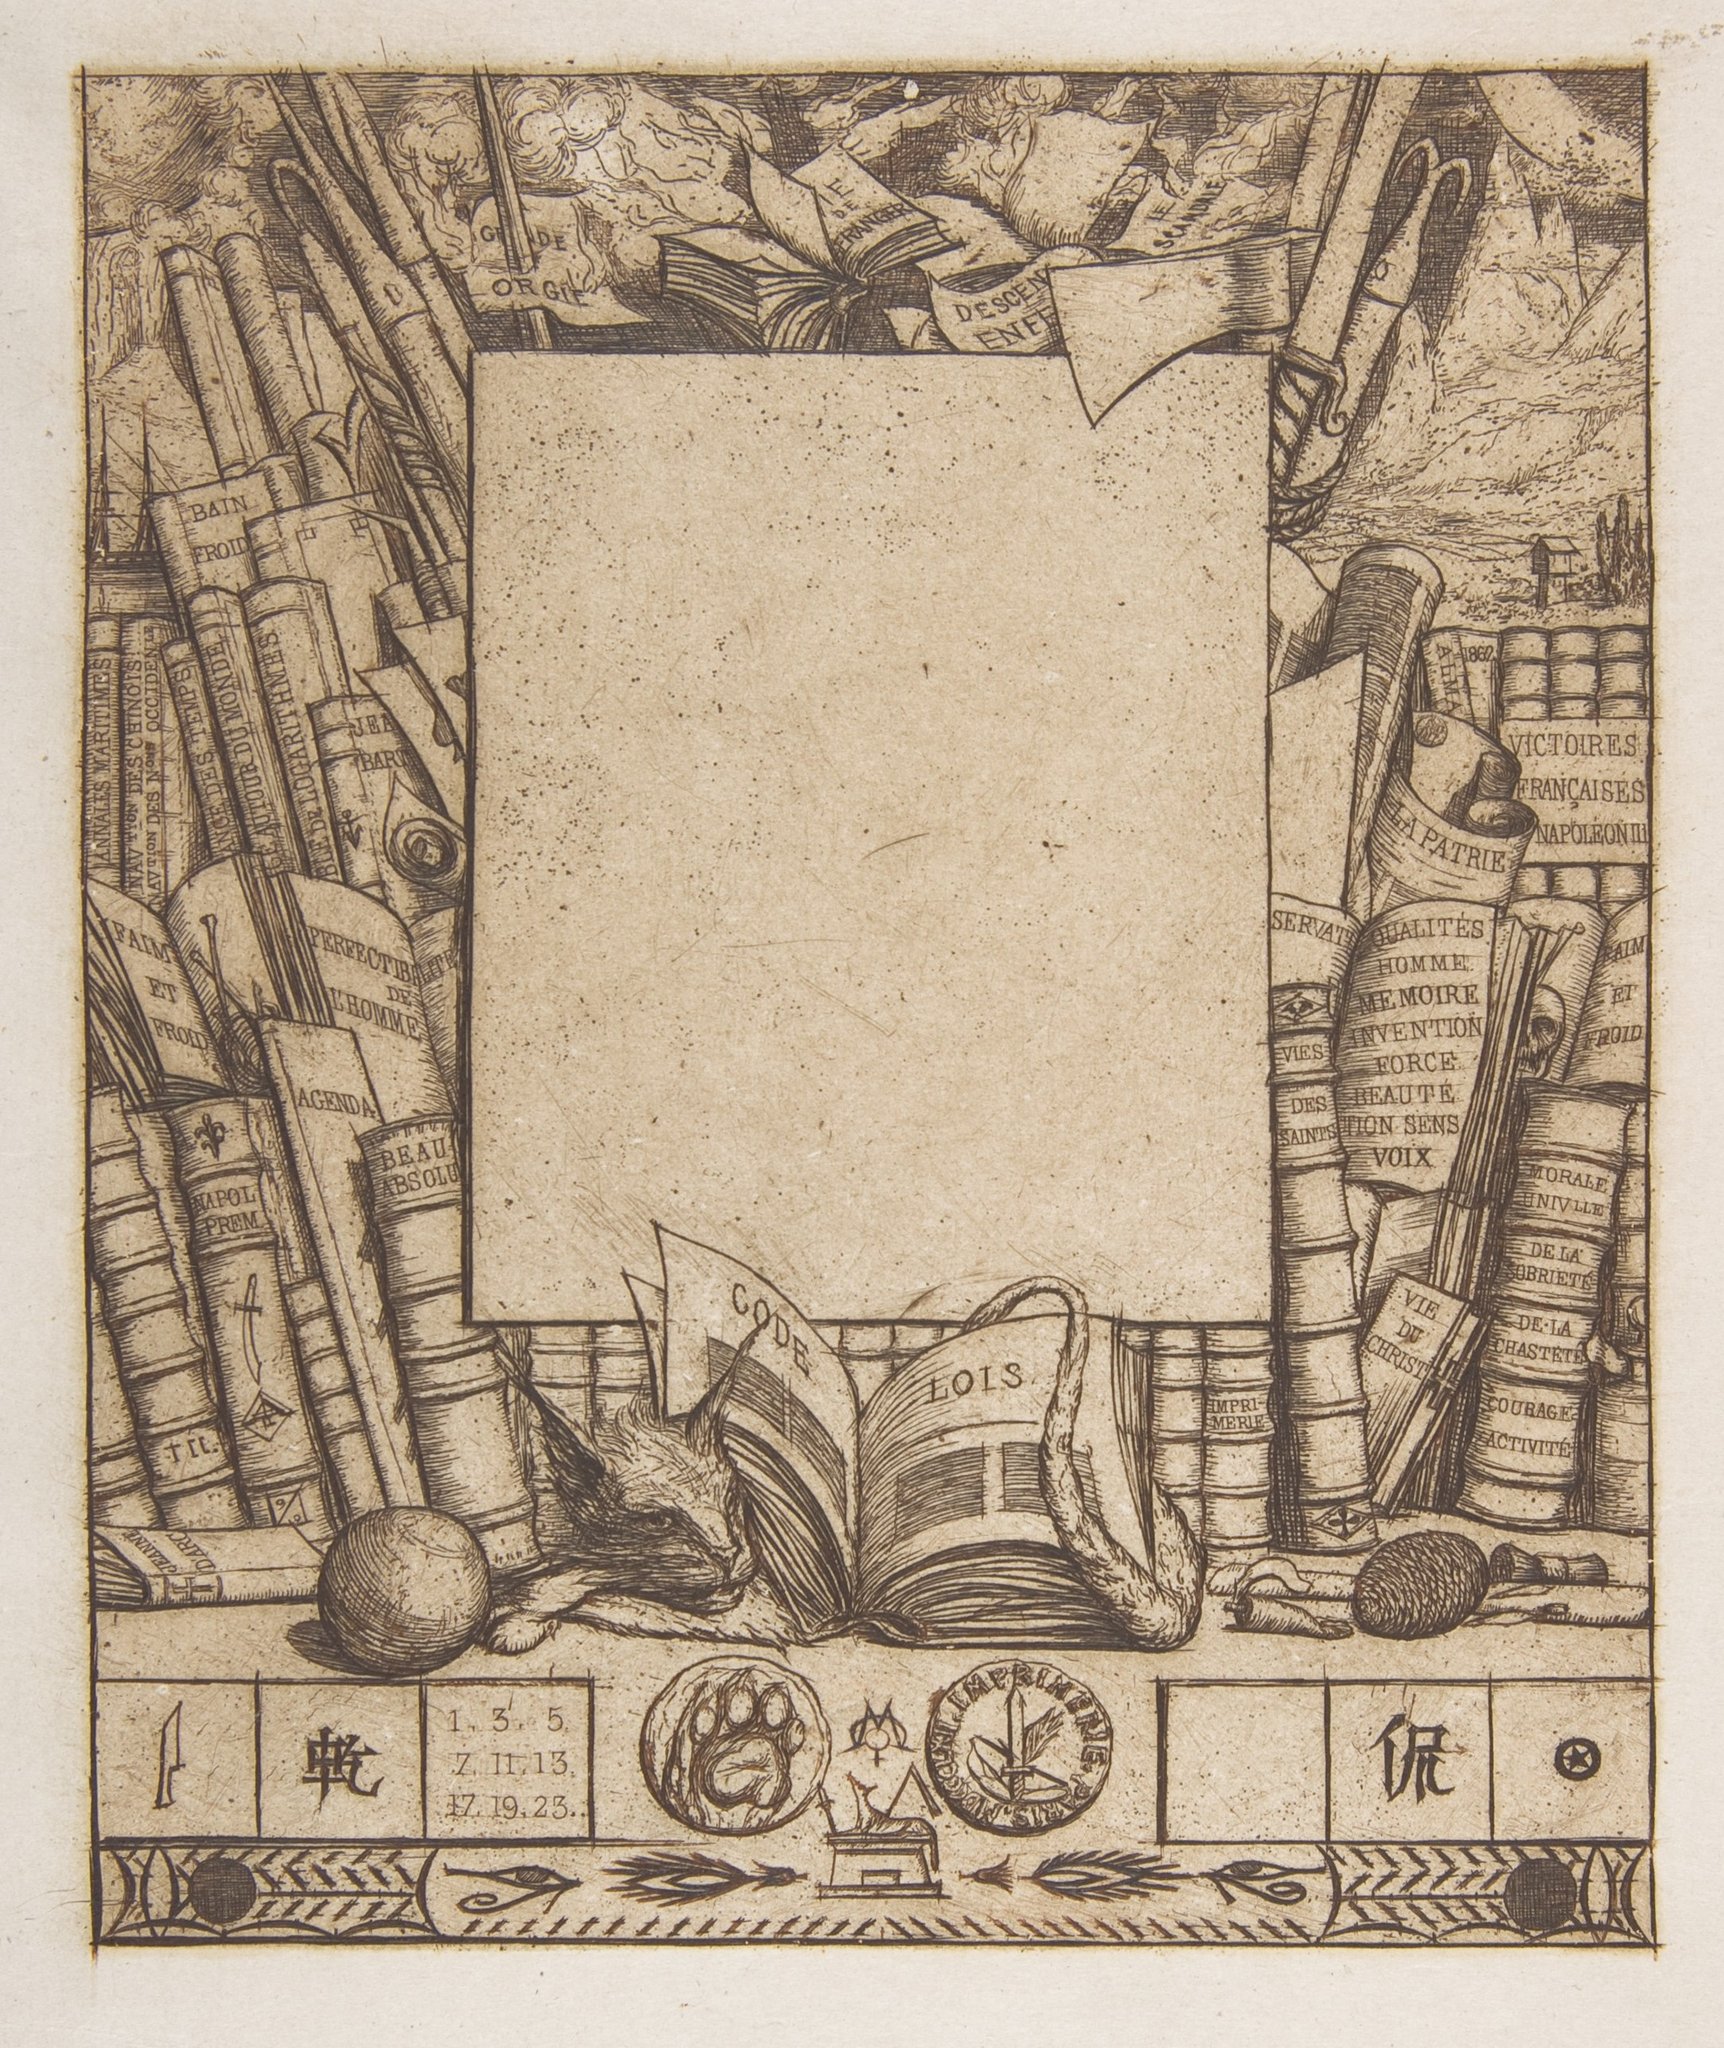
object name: print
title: Design for a frame for the portrait of Armand Guéraud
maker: charles meryon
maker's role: artist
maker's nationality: french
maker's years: 1821-1868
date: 1862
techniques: drypoint, etching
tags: books